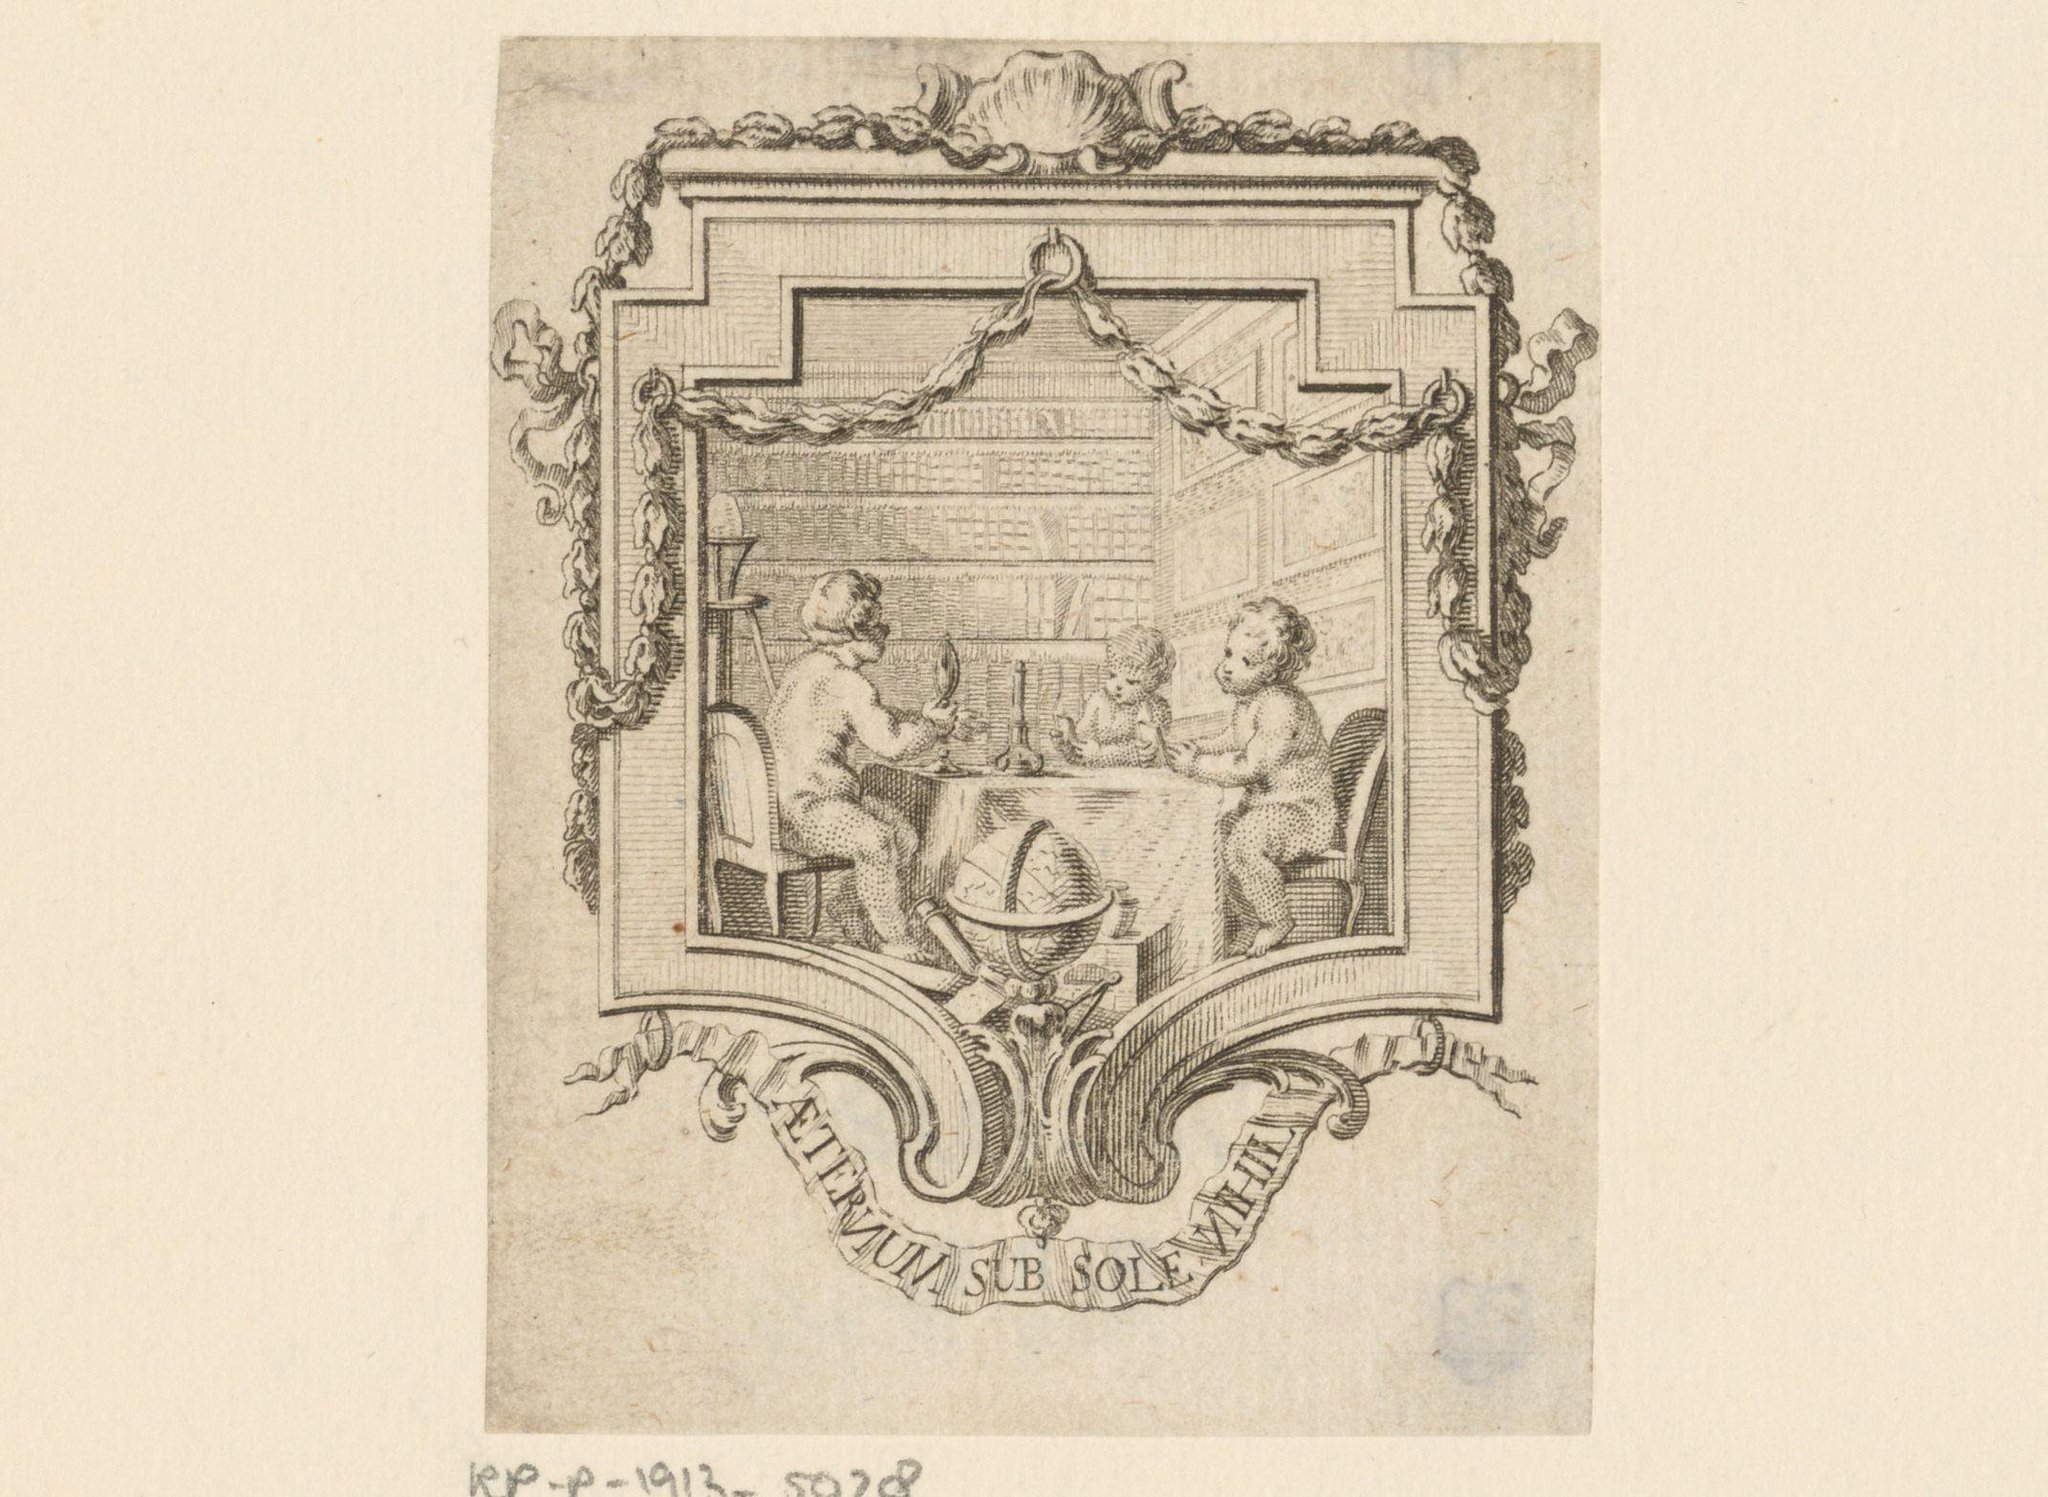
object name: bookplate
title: Aeternum sub sole nihil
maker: gabriel jacques de saint-aubin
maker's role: draughtsman, print maker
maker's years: 1724-1780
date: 1734-1780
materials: paper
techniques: engraving, etching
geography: france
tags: study; 'studiolo'; library, picture, painting, globe, cupids: 'amores', 'amoretti', 'putti'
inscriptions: collector's mark: Lugt 2233, collector's mark: Lugt 2760